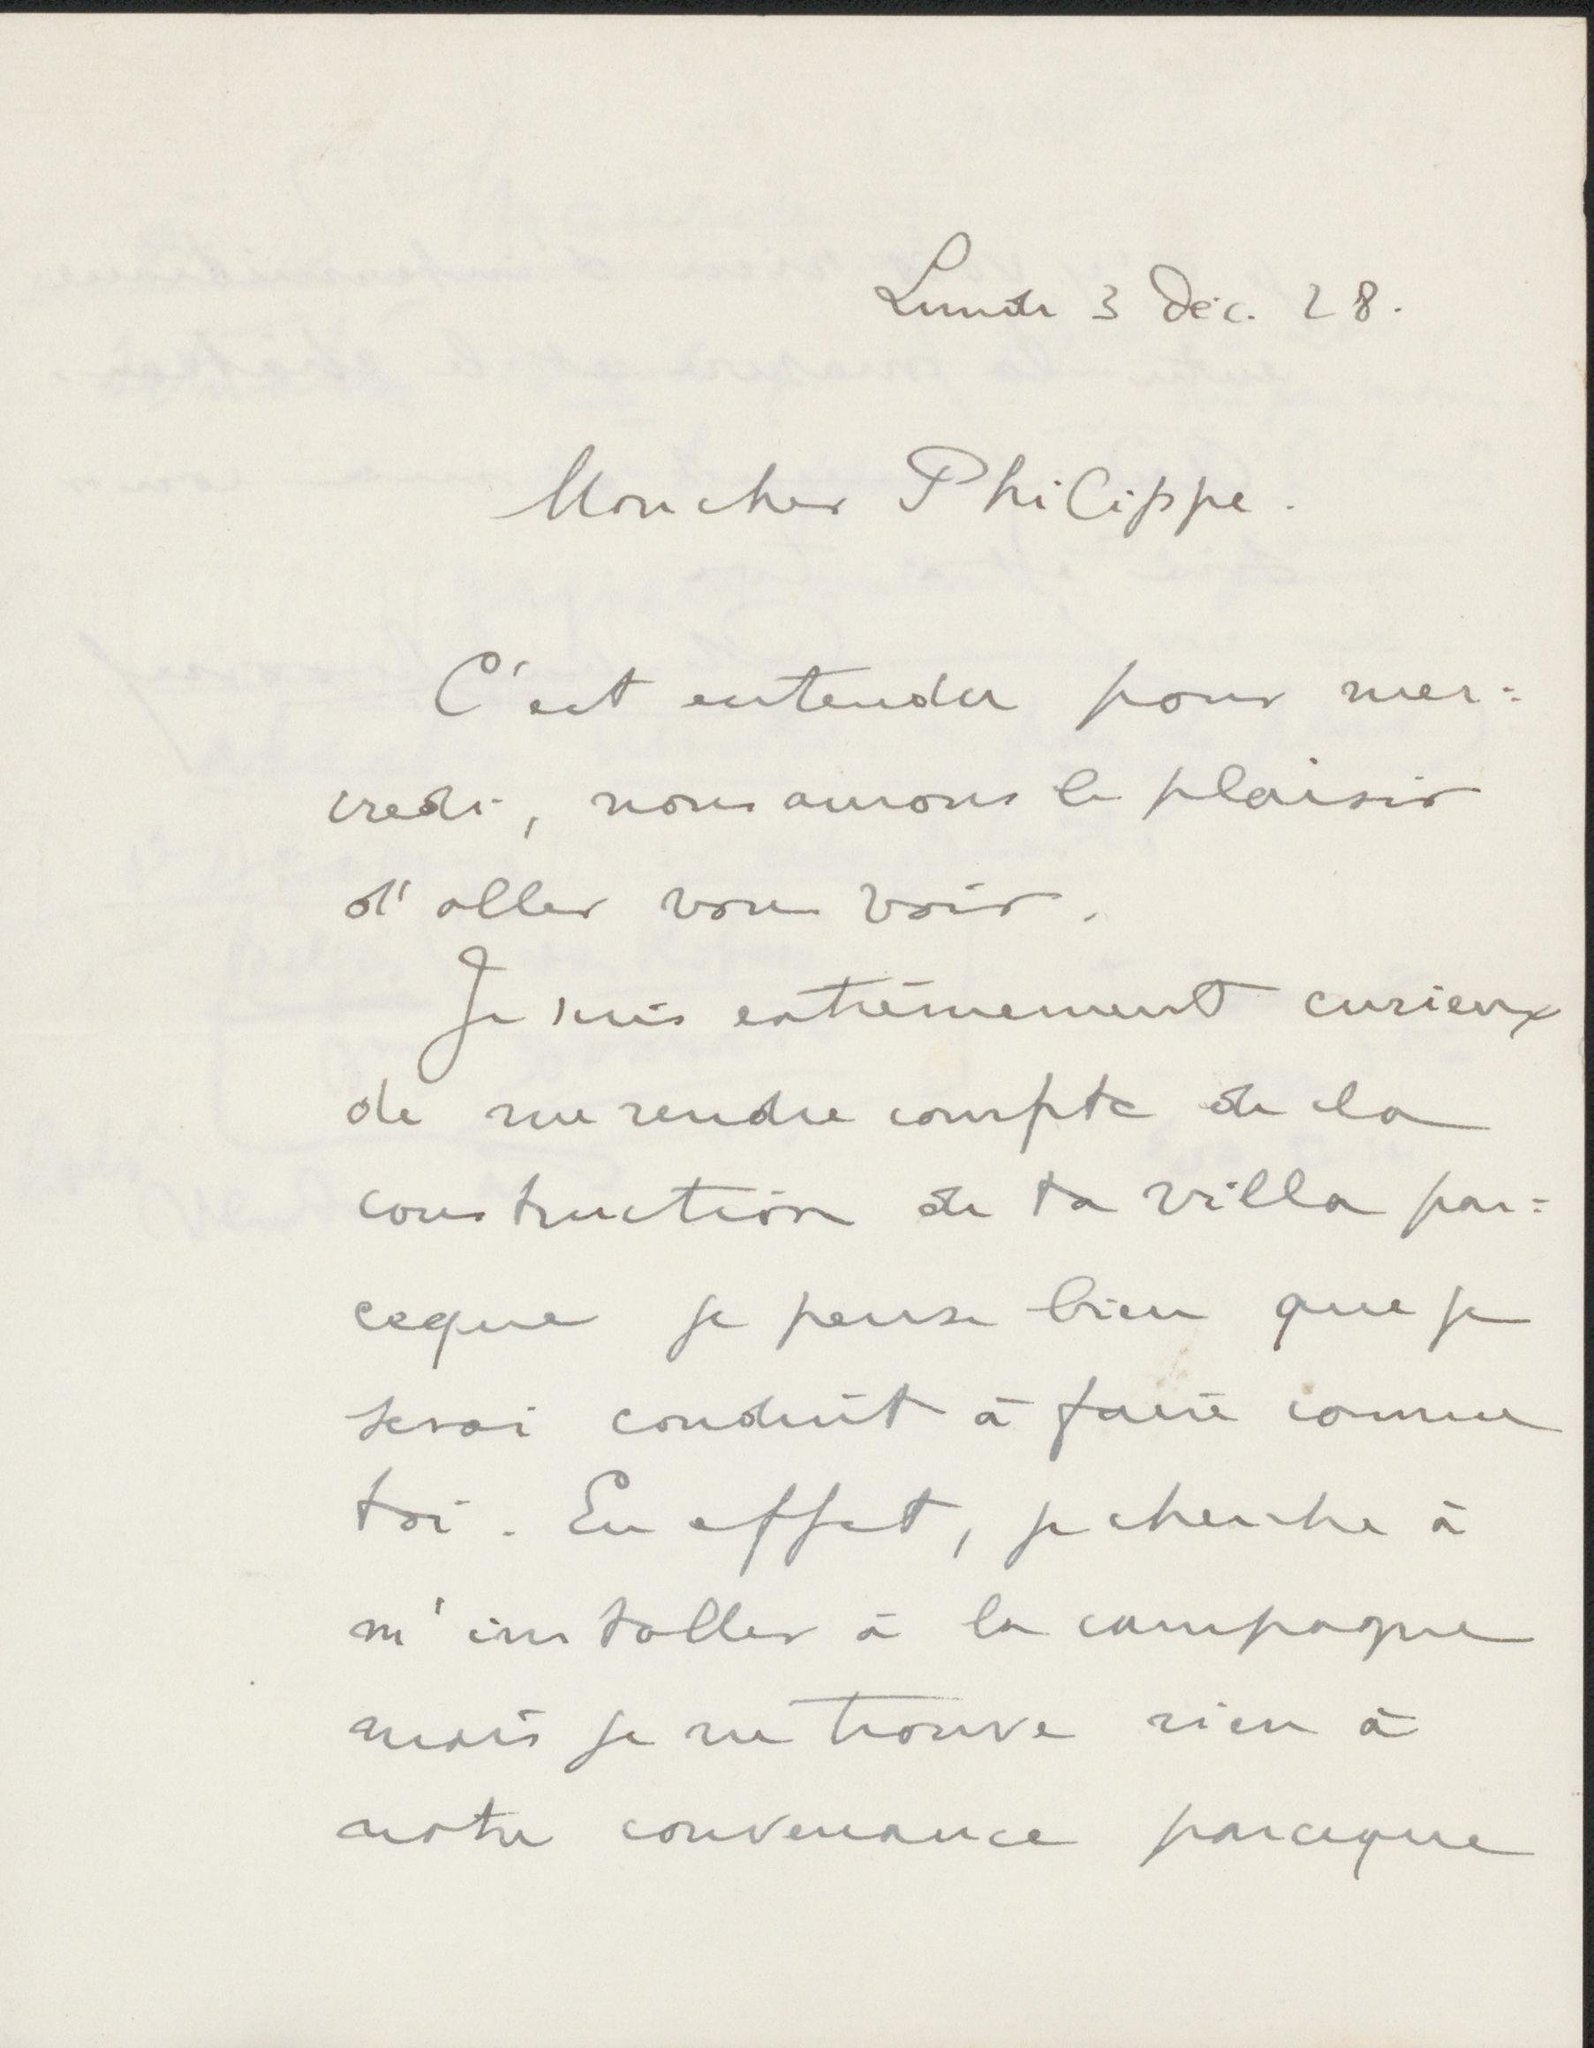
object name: letter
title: Brief aan Philip Zilcken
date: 1928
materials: ink, paper, pencil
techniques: pen, writing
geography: nice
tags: the hague, painter, draughtsman, philip zilcken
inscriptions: watermark, collector's mark: ‘RPK’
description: Brief bevat aantekening van Philip Zilcken.